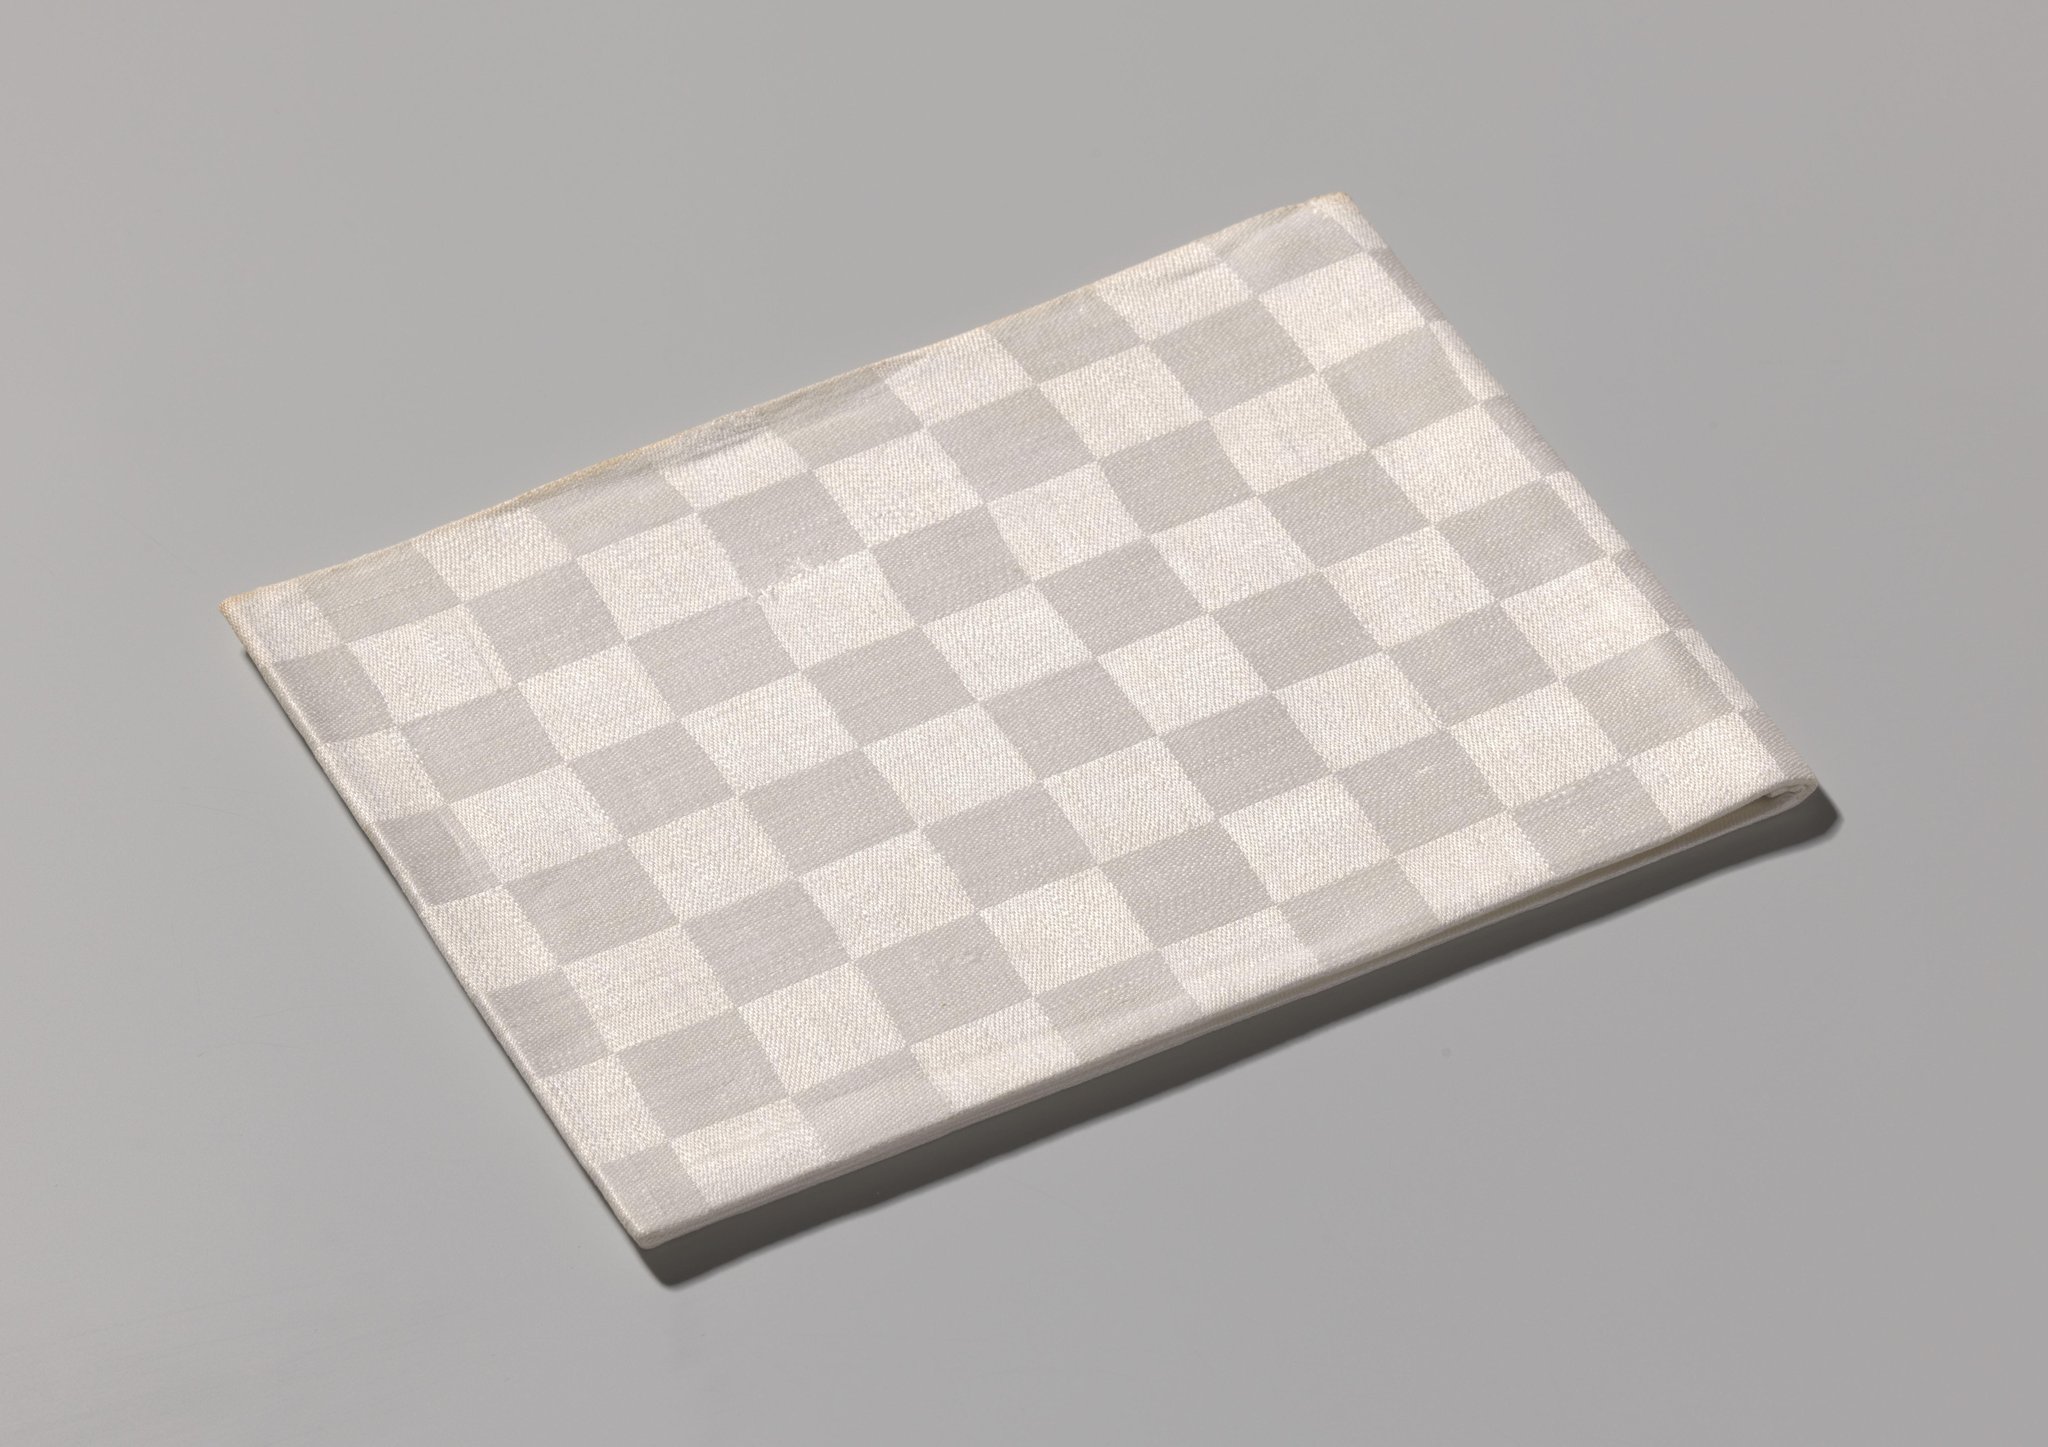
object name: napkin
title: Servet van linnen met pellenpatroon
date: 1725-1775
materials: linen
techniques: peeled fabric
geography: northern netherlands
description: wit linnen servet met pellen patroon, merk ARVG 13